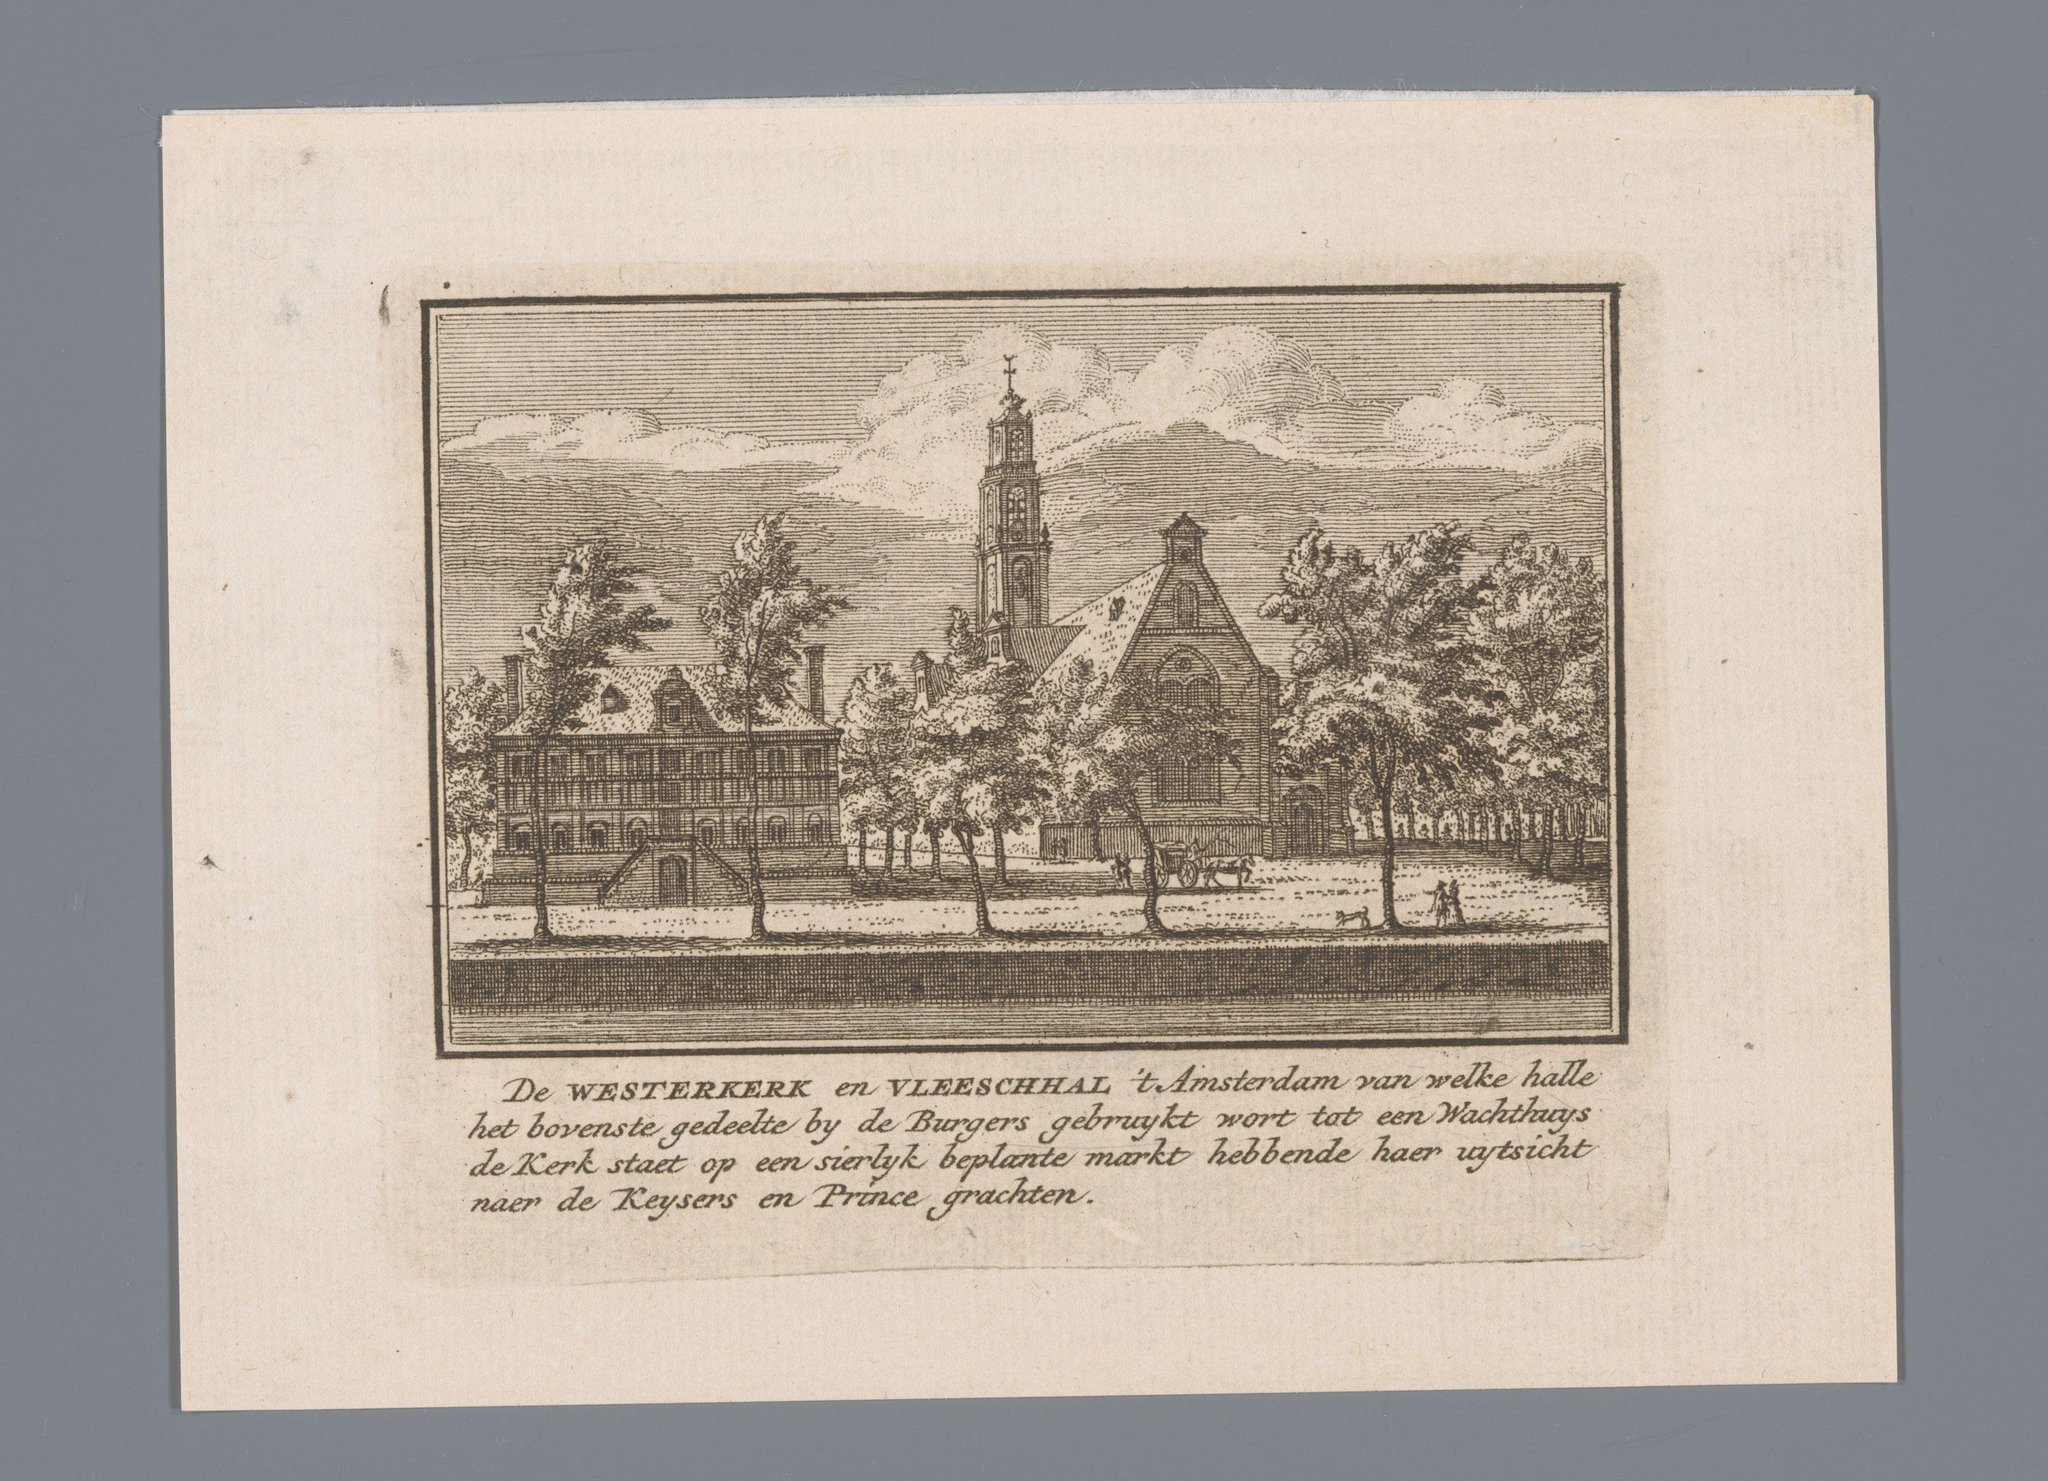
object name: print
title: Gezicht op de Westerkerk en Westerhal te Amsterdam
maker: Anonymous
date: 1725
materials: paper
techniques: etching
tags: protestant churches and denominations, exterior ~ representation of a building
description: Prent naar een prent van Abraham Rademaker in: Kabinet van Nederlandsche outheden en gezichten (...). Amsterdam: Willem Barents, 1725, ill. nr. 17.